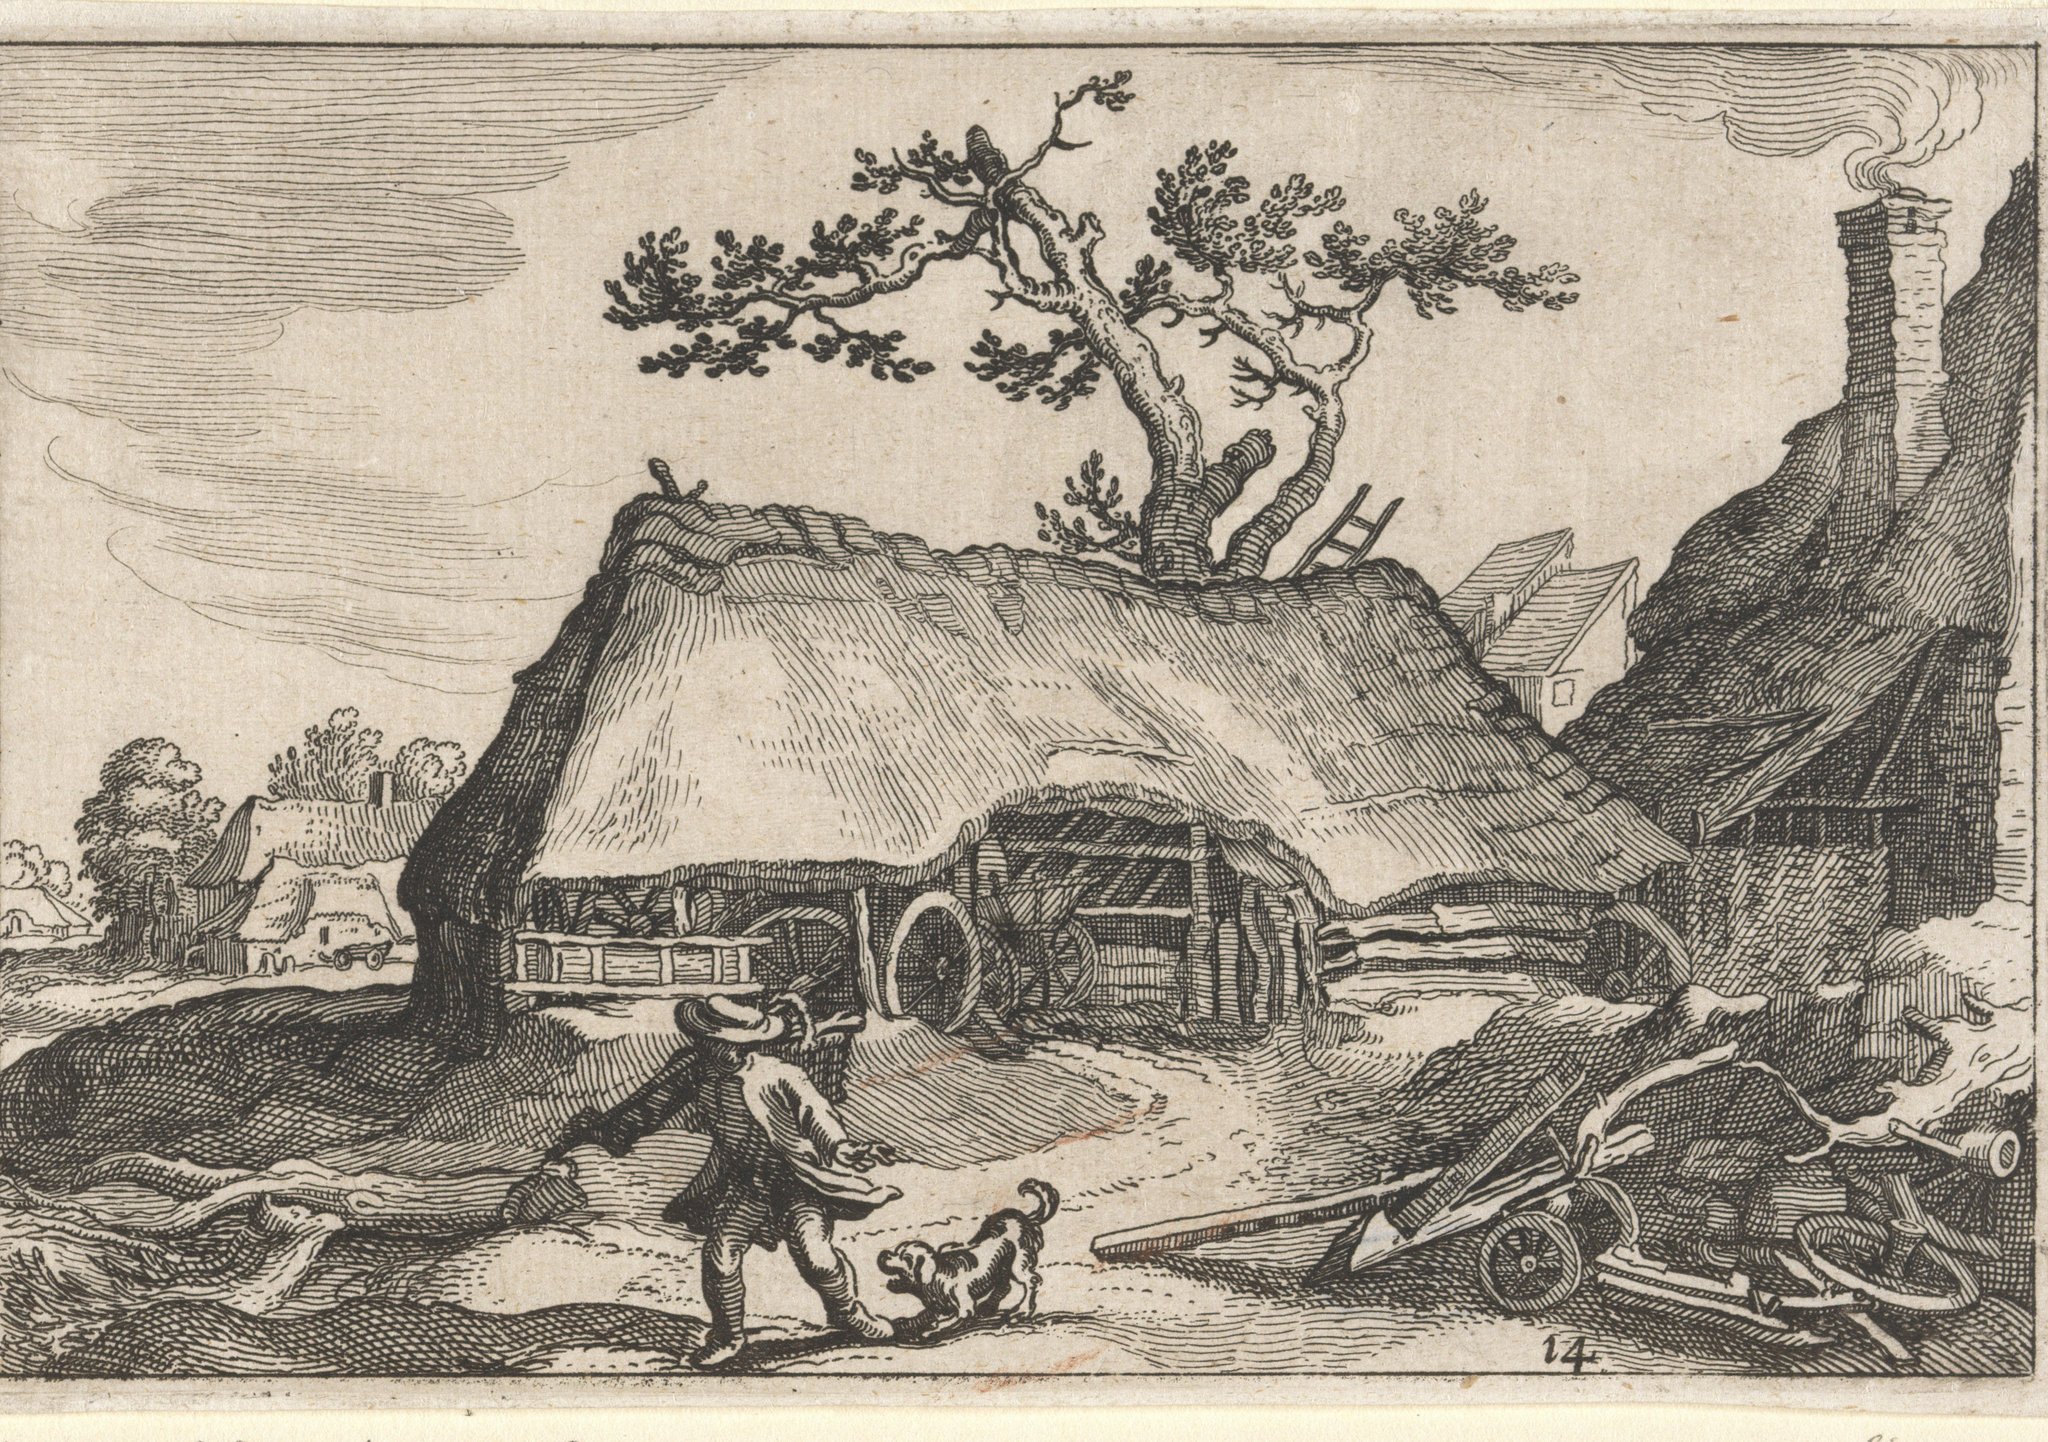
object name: print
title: Landschappen met boerderijen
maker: claes jansz. visscher (ii)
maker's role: draughtsman, print maker, publisher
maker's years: 1586-1652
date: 1620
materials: paper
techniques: etching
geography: amsterdam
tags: watch-dog, dog watching, farm or solitary house in landscape, (farm) wagon, freight wagon, cart, farm (building)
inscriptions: collector's mark: Lugt 2228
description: Gezicht op een landschap met een boerderij. Op de voorgrond blaft een hond naar een man.